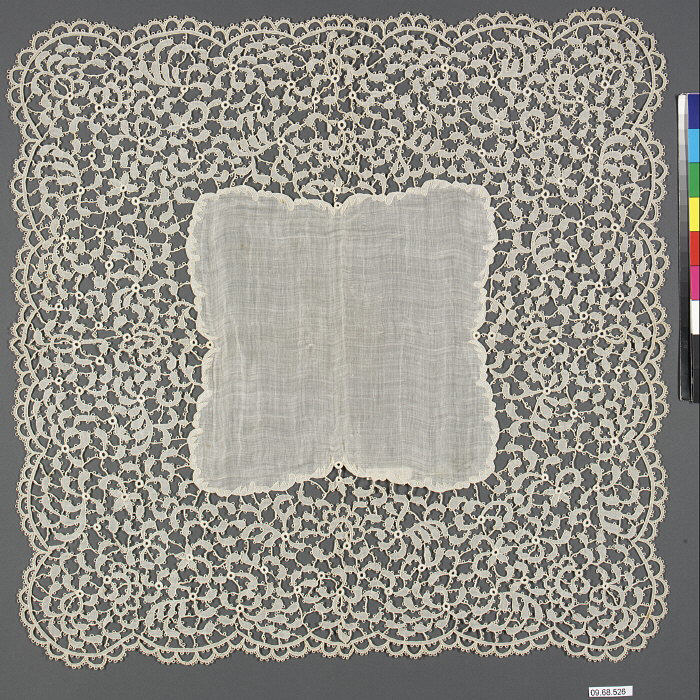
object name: handkerchief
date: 1801-1900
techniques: embroidery